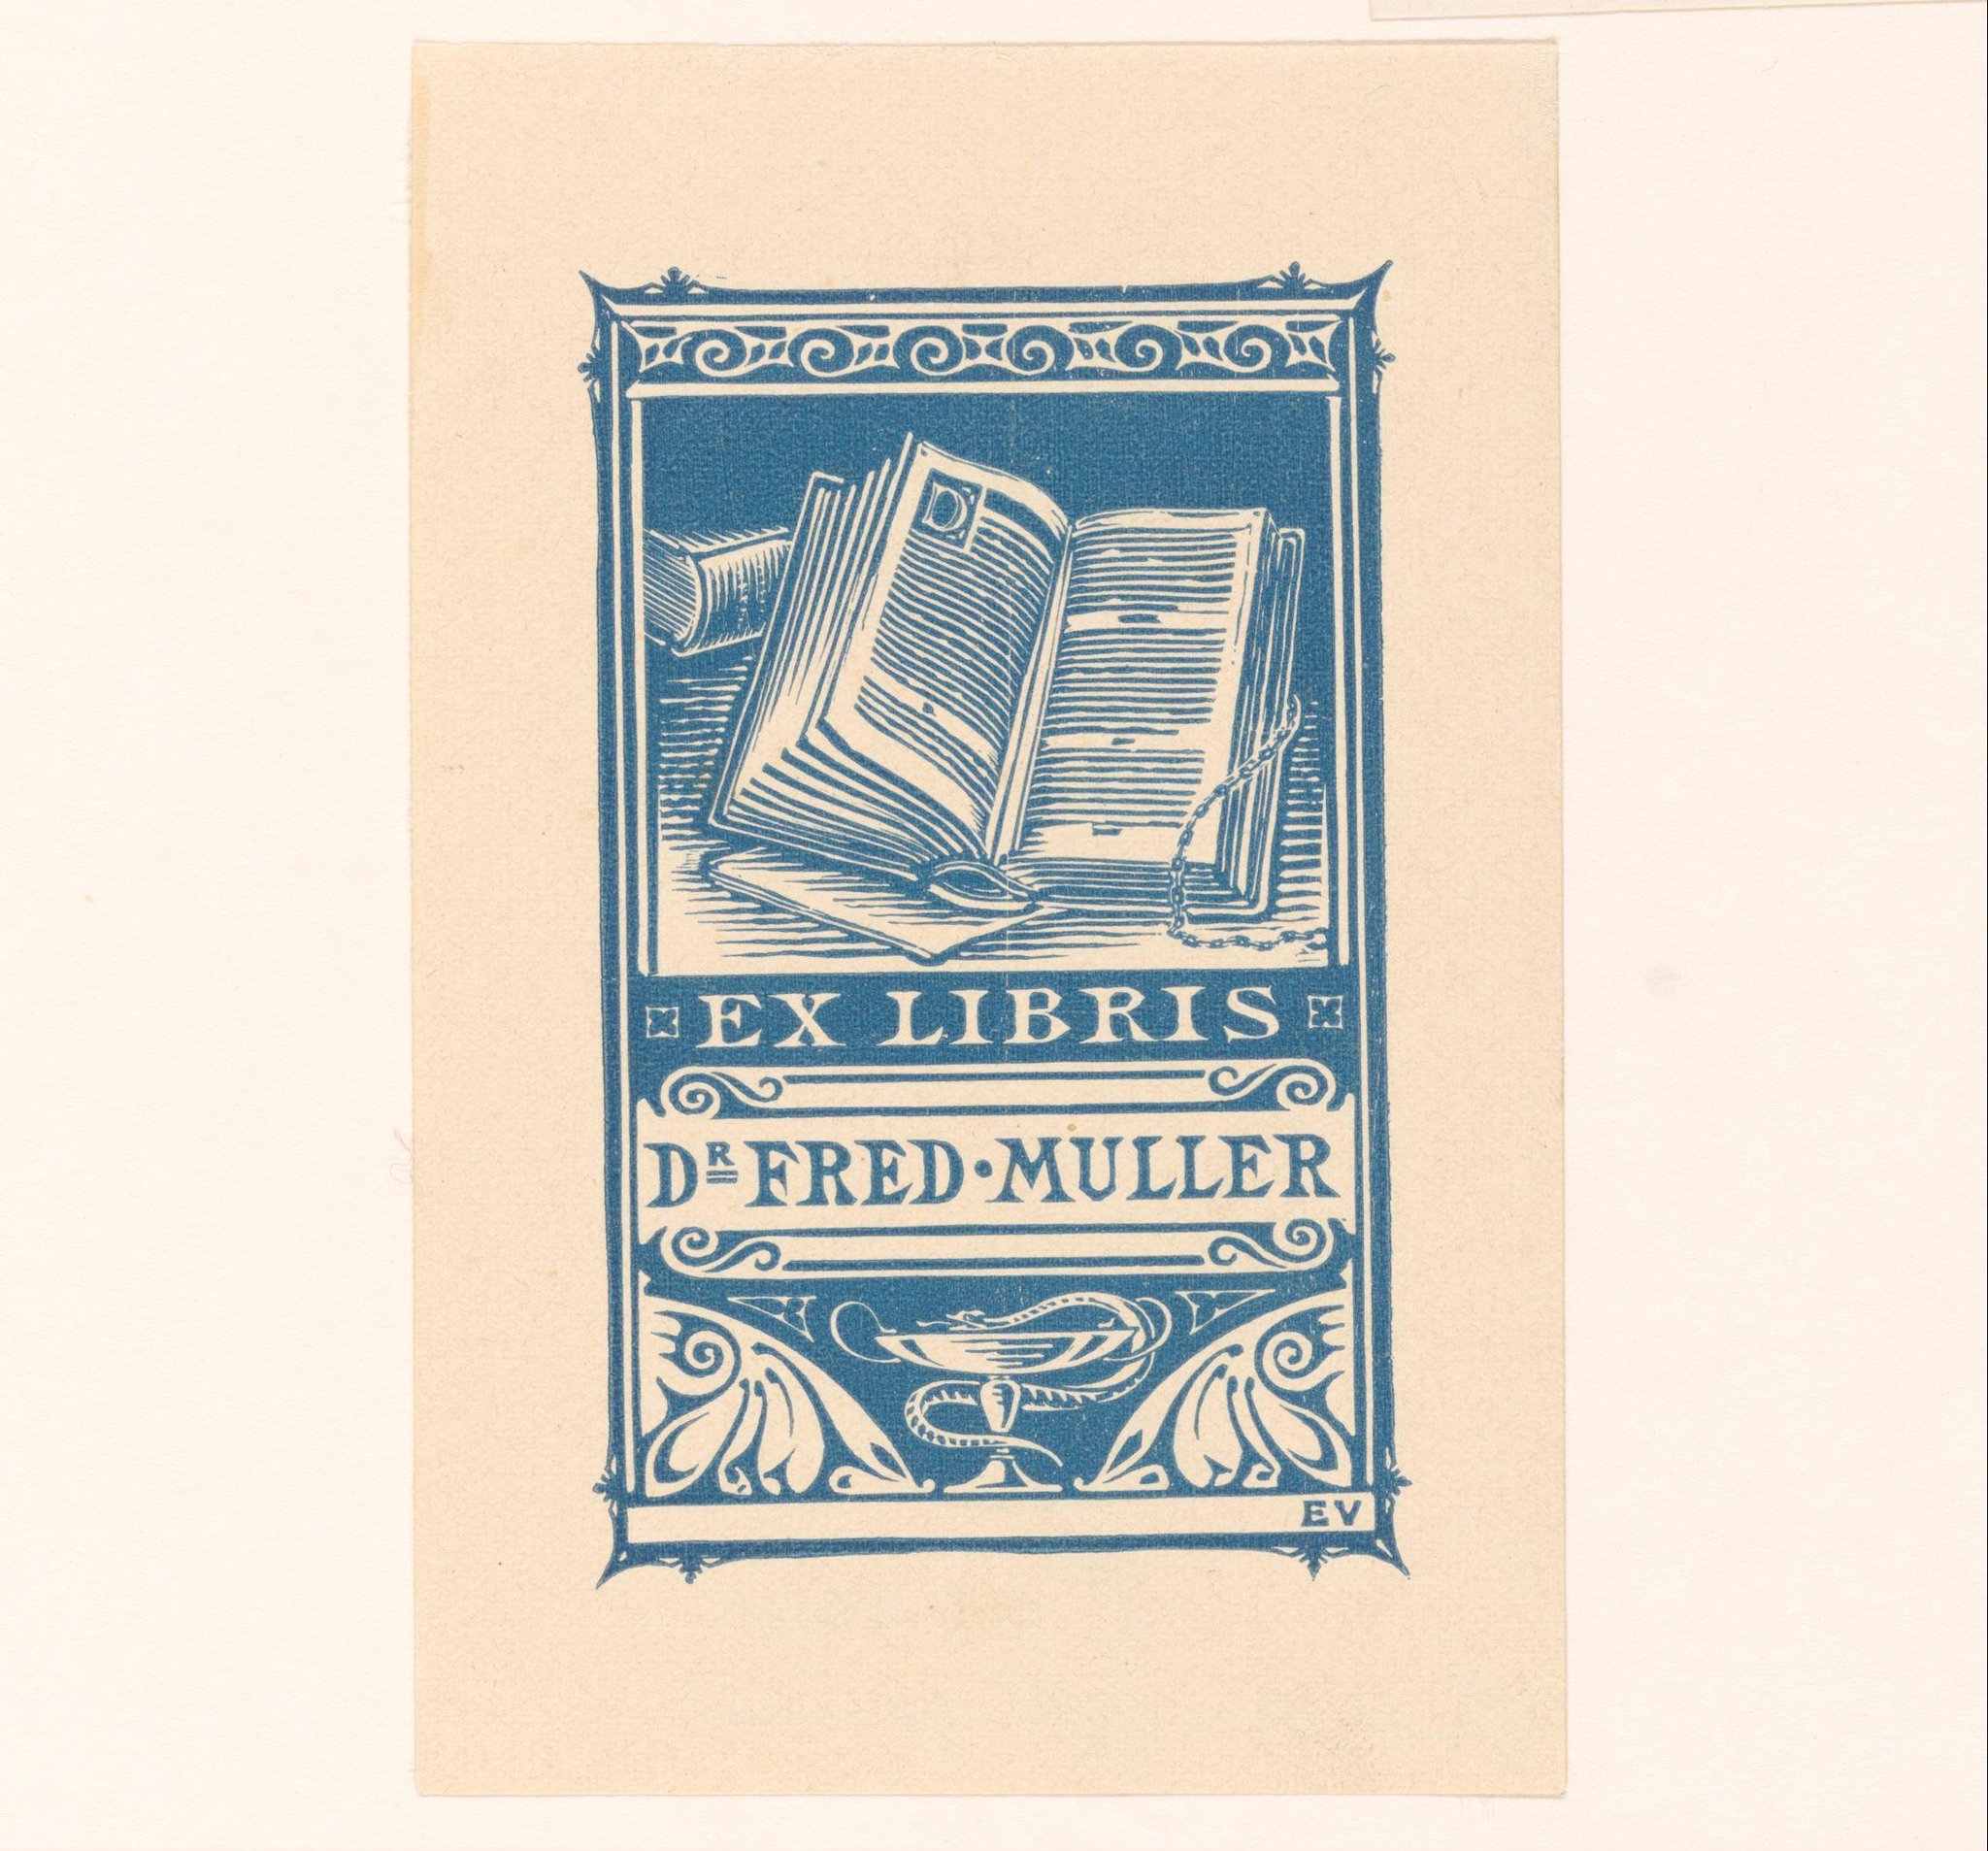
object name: bookplate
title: Ex libris van Frederik Muller Jzn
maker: elias voet jr.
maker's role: jeweler, print maker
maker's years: 1868-1940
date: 1893-1940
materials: paper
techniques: woodcut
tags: book - mm - book open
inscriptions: collector's mark: Lugt 2228